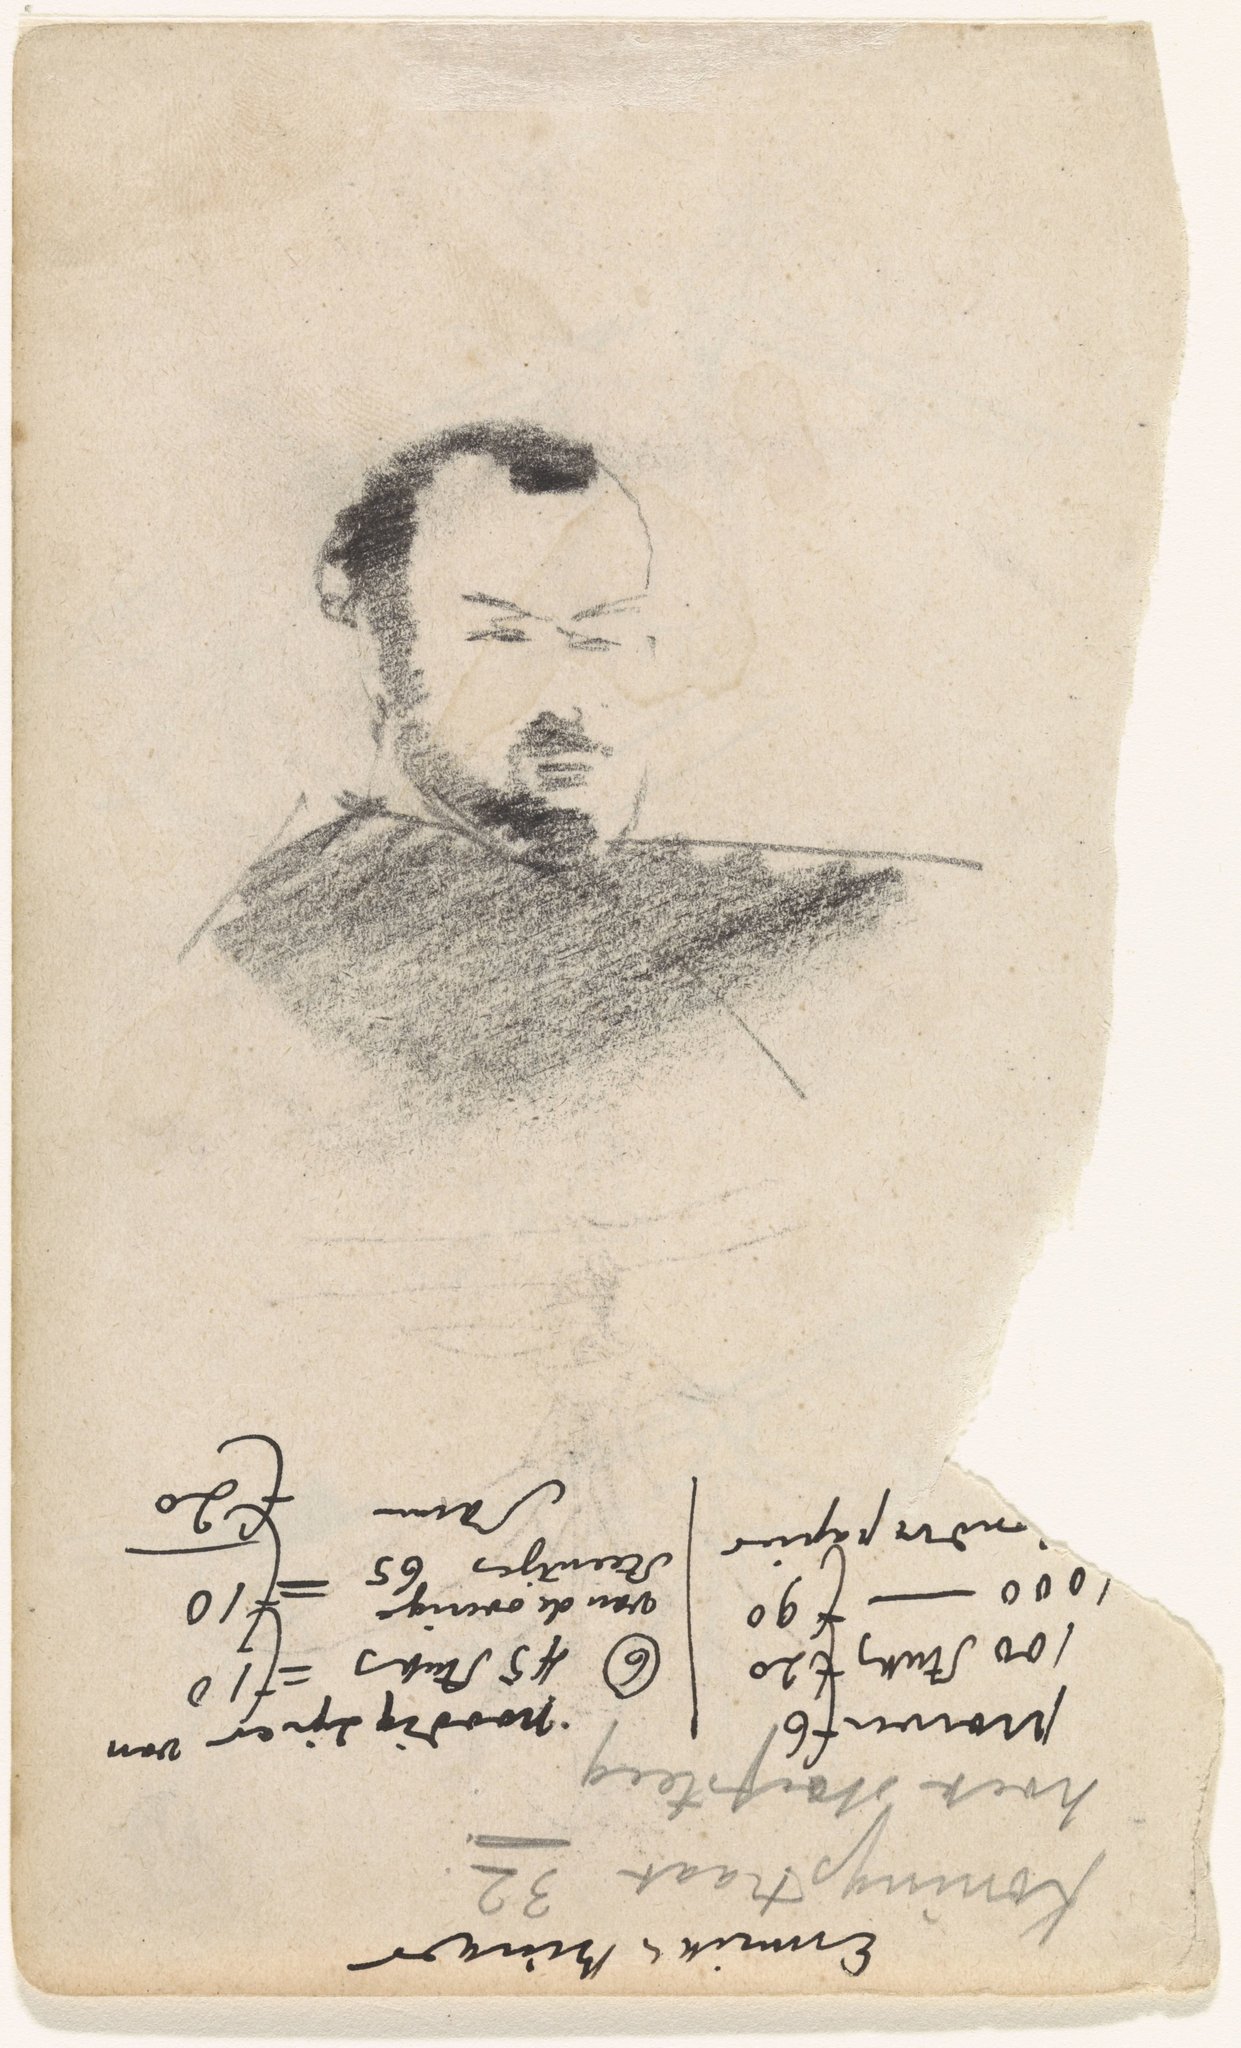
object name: drawing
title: Manskop en notities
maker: gerrit willem dijsselhof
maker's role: designer, draughtsman, print maker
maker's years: 1866-1924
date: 1876-1924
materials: chalk, paper